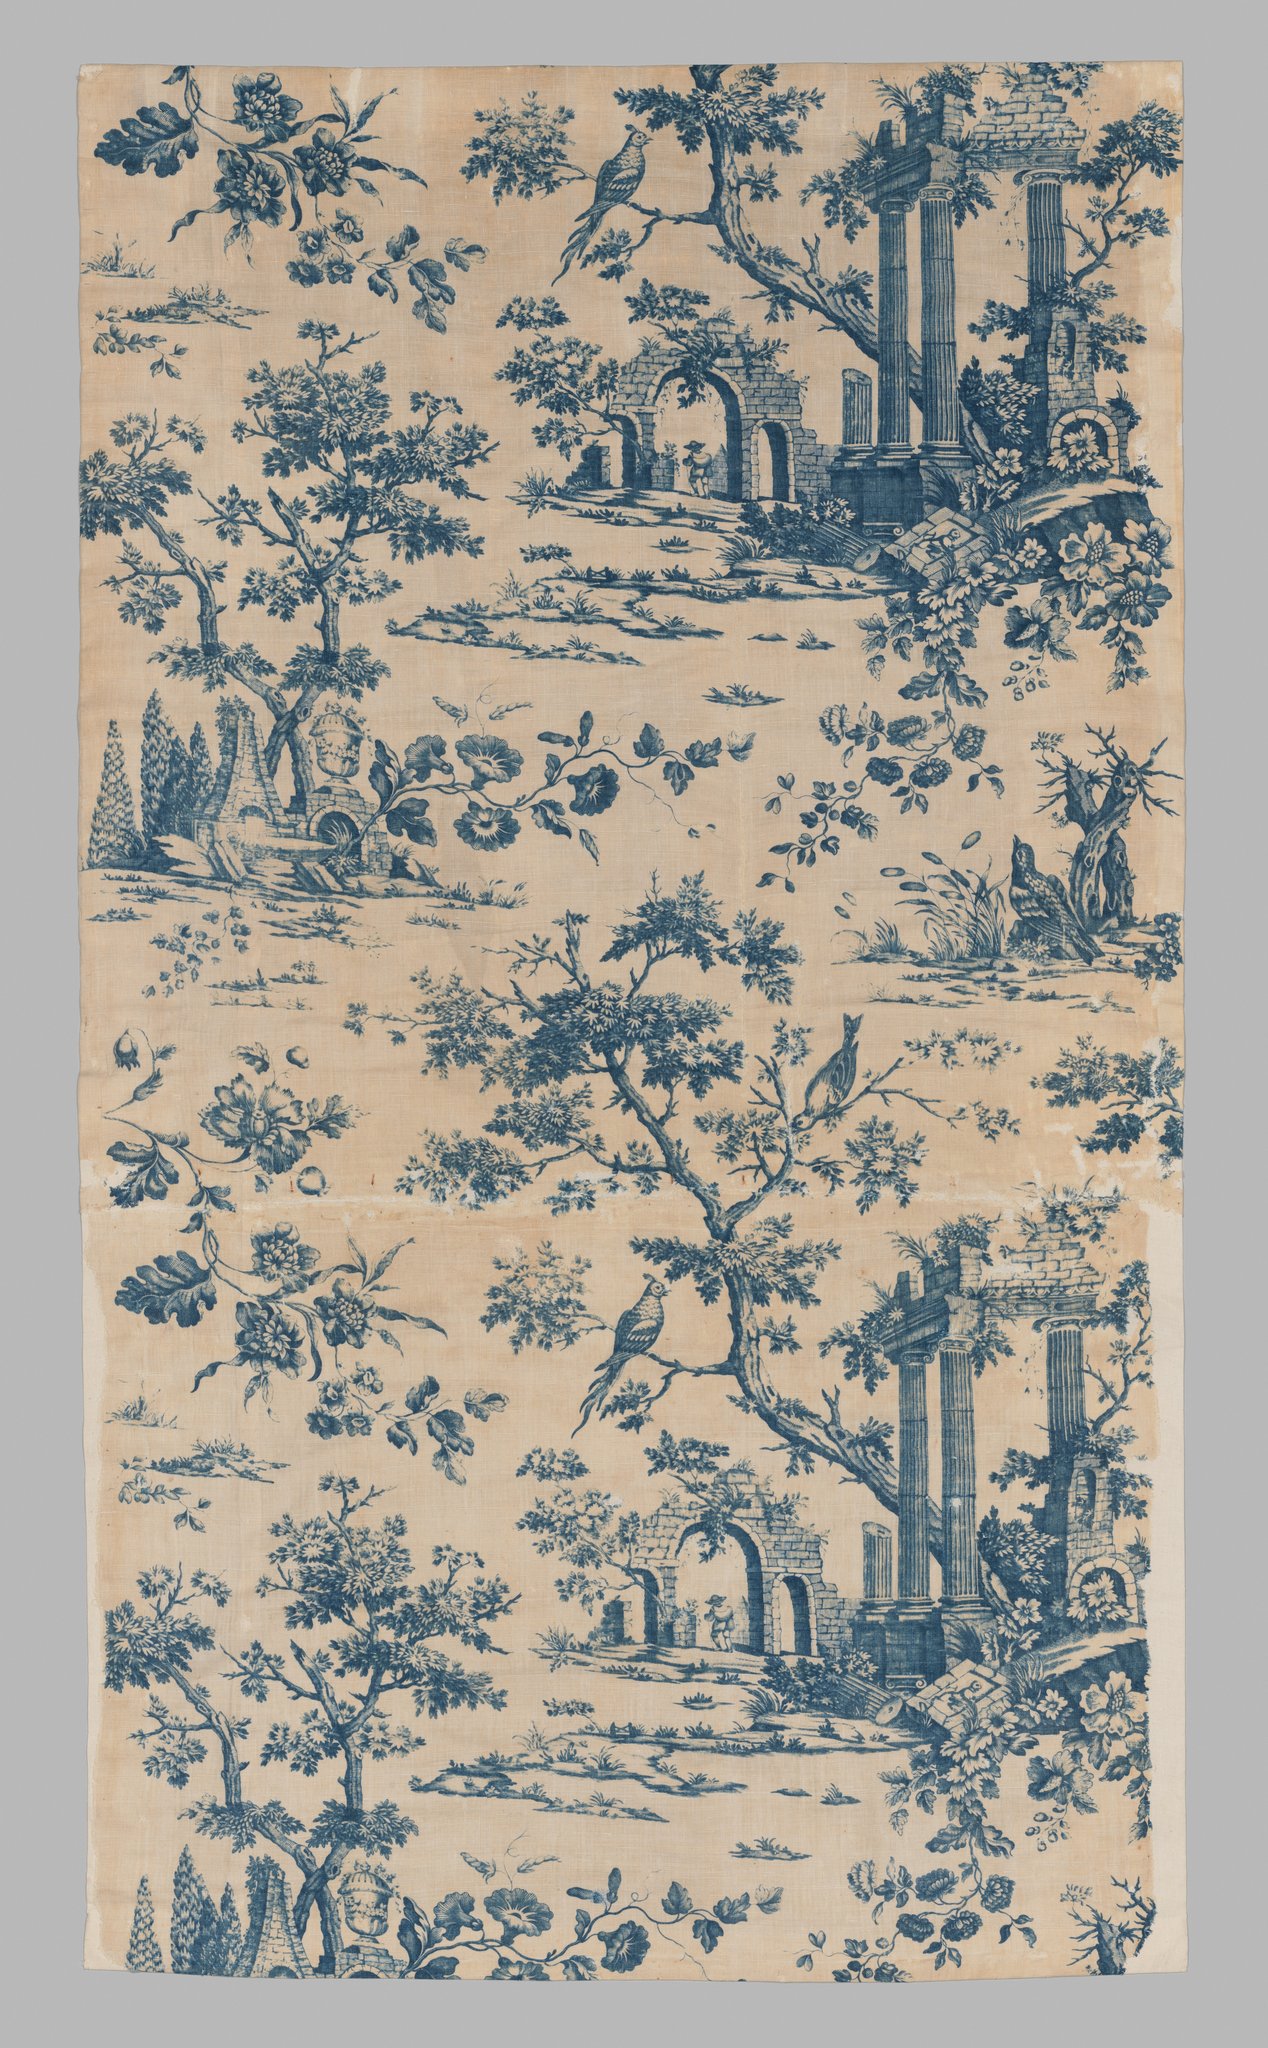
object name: piece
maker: john munns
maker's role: manufactory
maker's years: 1725-1825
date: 1770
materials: textile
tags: birds,ruins